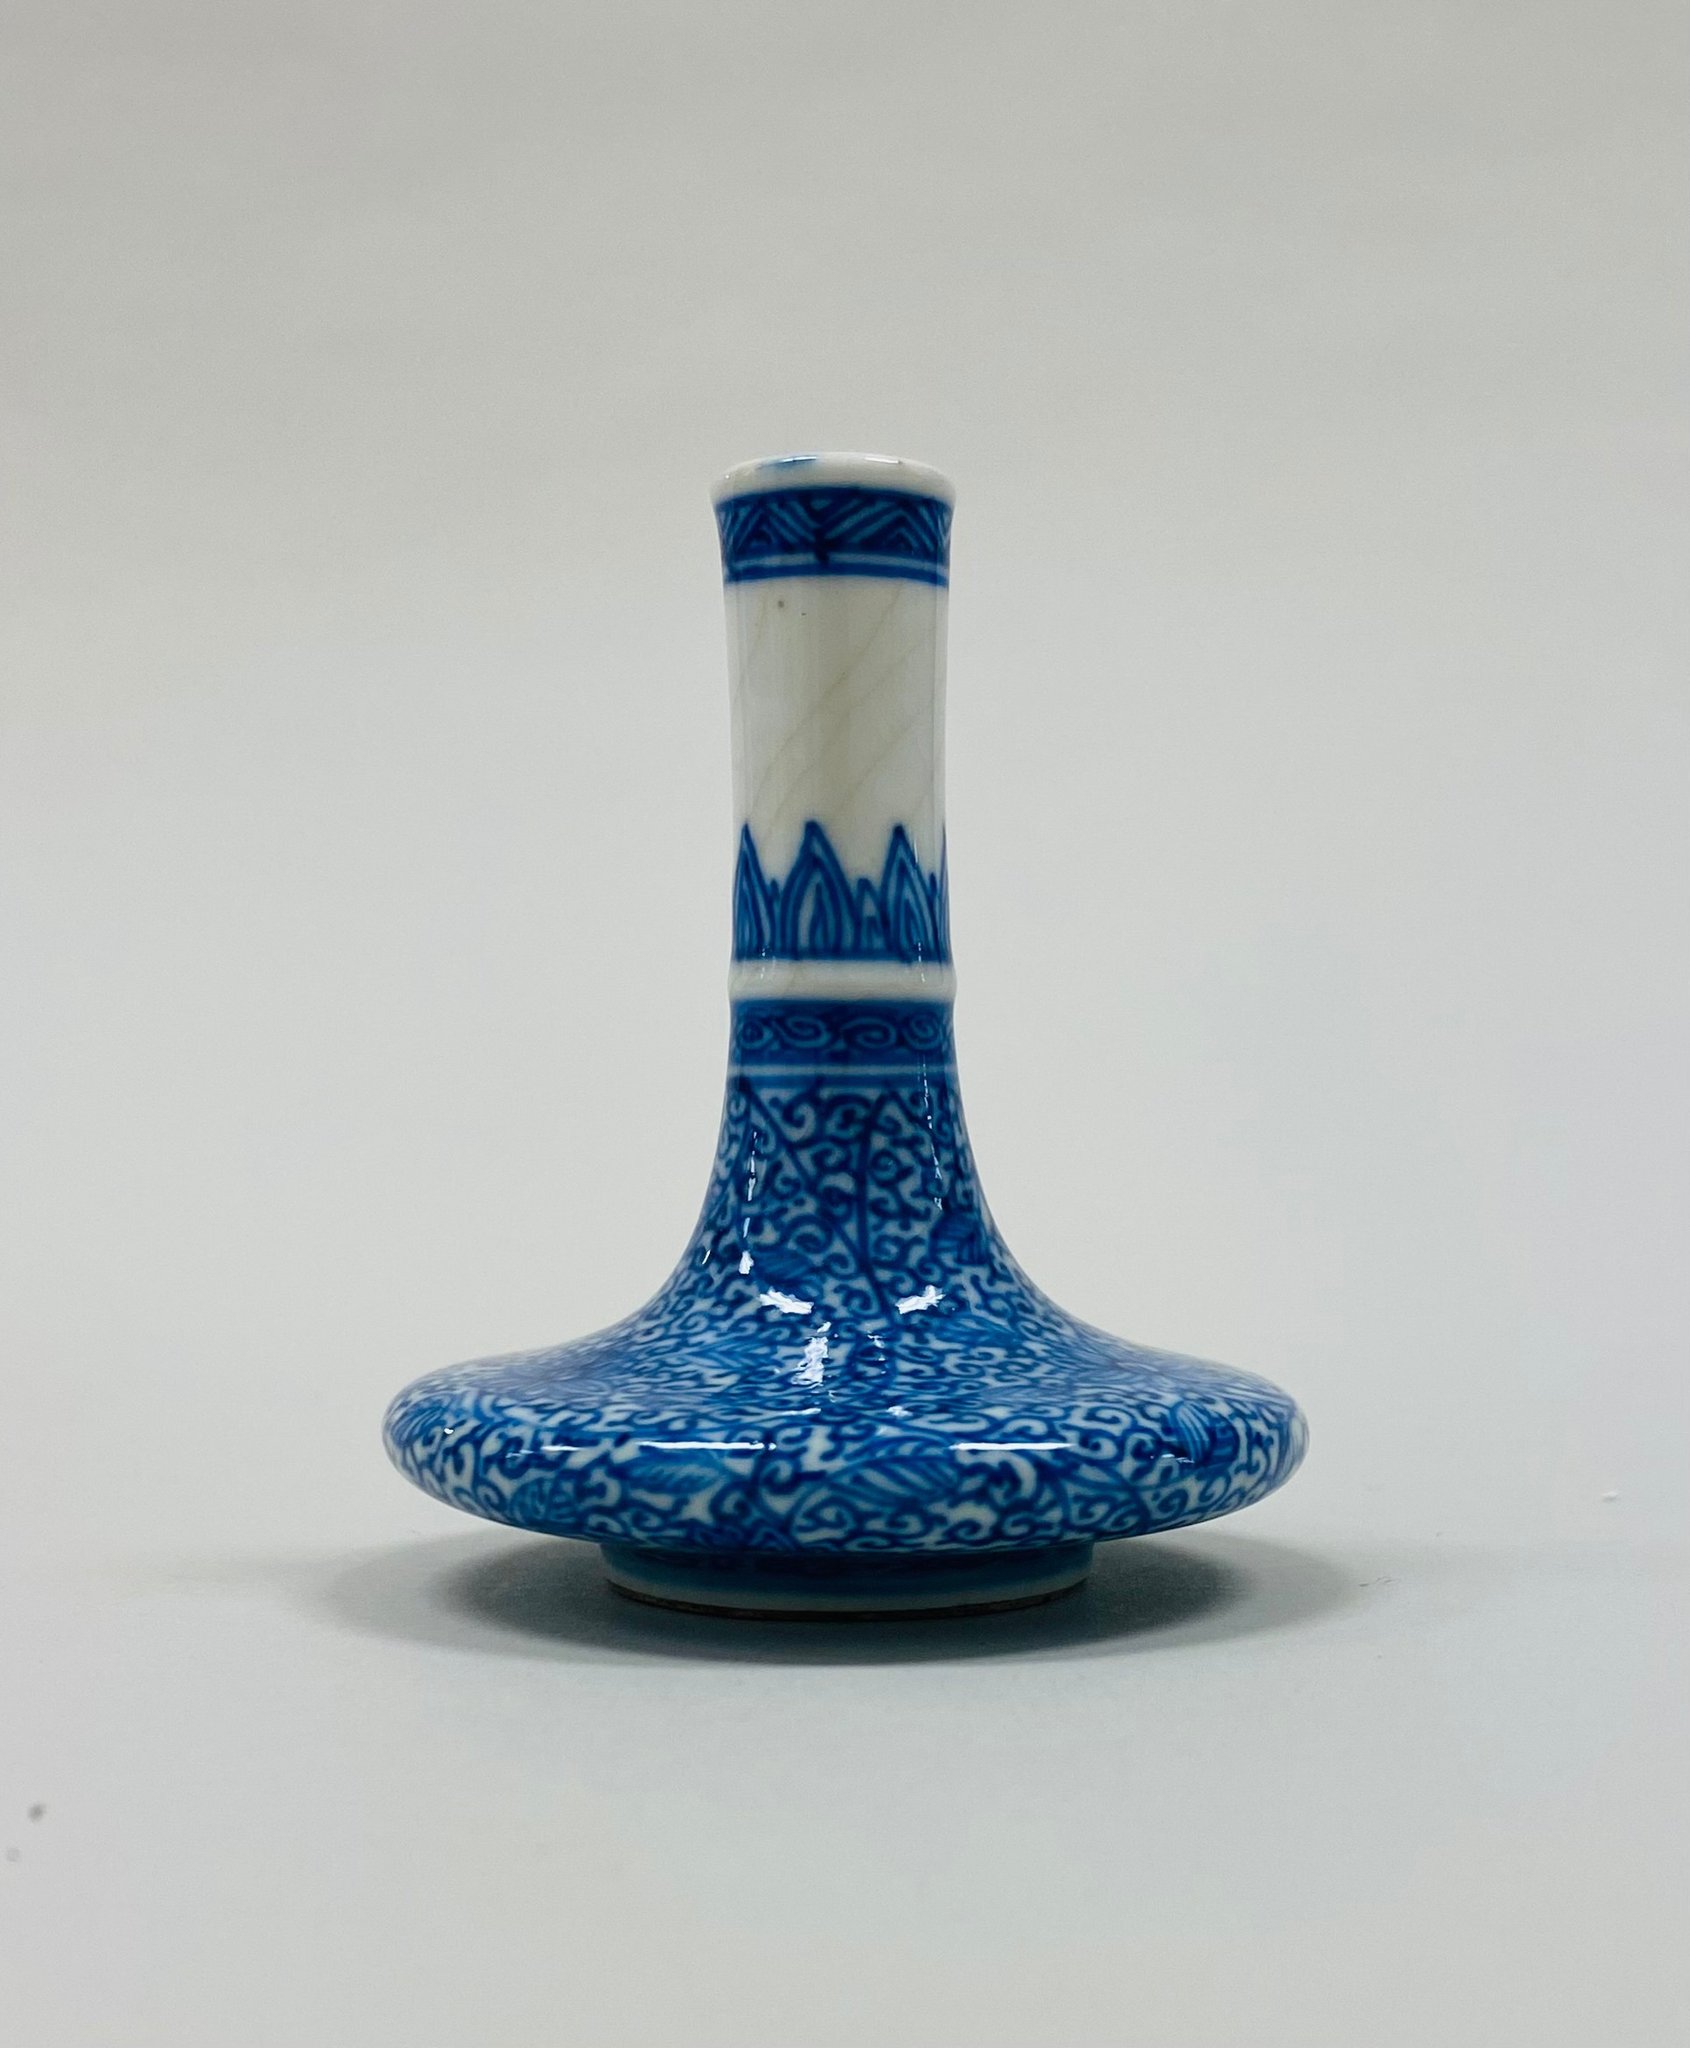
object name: minature vase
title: Minature vase with floral scrolls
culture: chinese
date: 1701-1733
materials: cobalt, porcelain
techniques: painting, underglaze